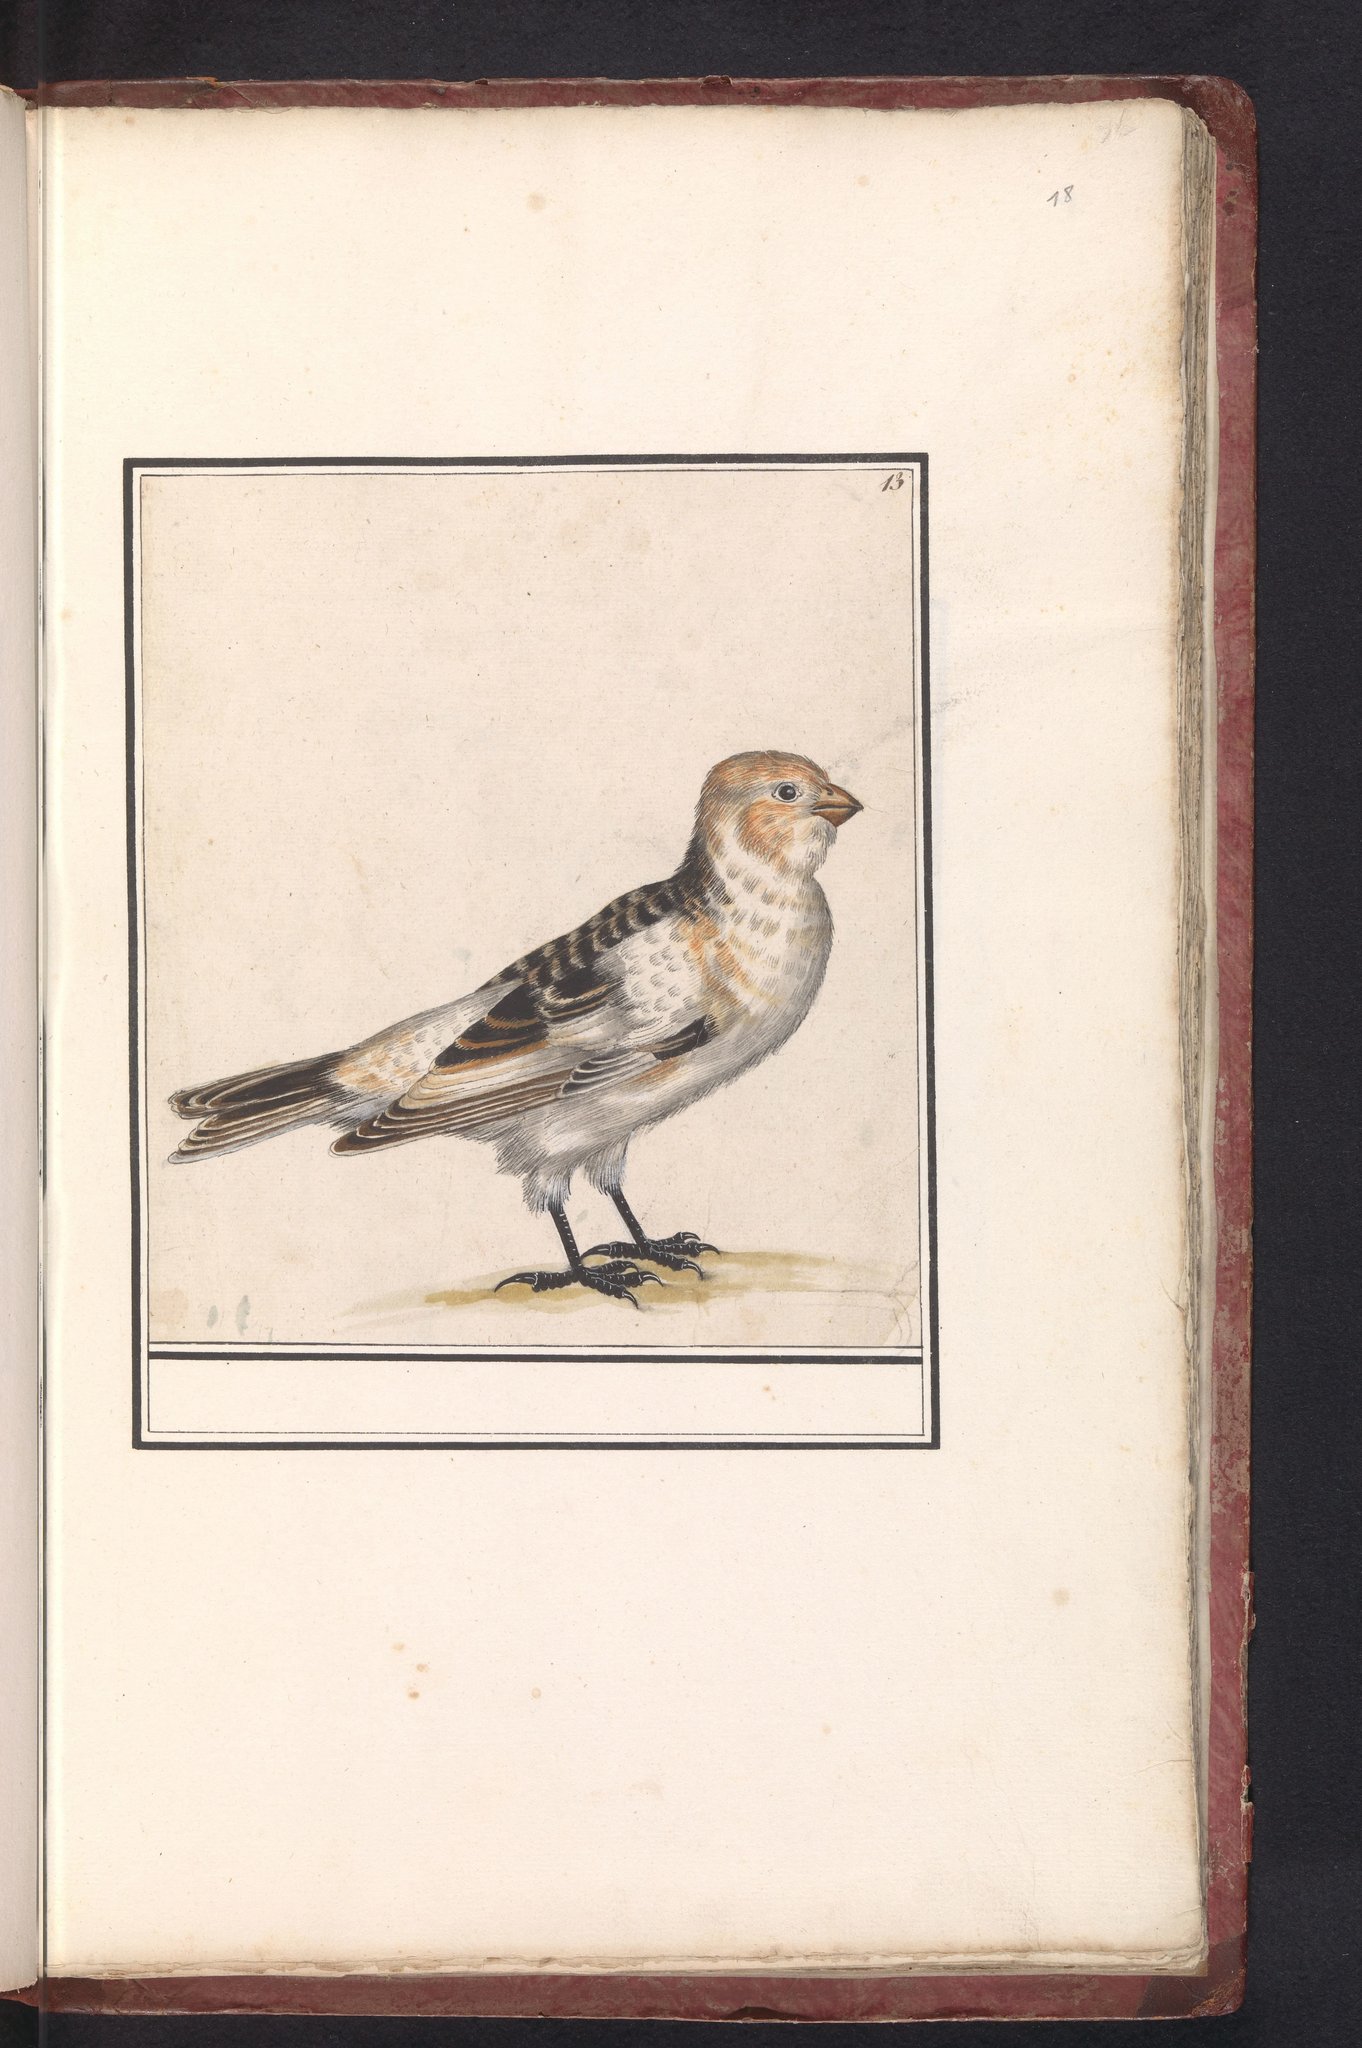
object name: drawing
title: Snow Bunting (Plectrophenax nivalis)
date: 1596-1610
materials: paint, paper, pencil, watercolor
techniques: brush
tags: song-birds: snow bunting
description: While in Prague, De Boodt could study living animals from distant lands in Rudolf II’s menagerie (zoo). He also had access to preserved specimens in the emperor’s Kunstkammer (Cabinet of Curiosities). Additionally, he relied on existing images to depict certain creatures. In the case of this snow bunting, De Boodt could simply observe it in the wild. Although the songbird breeds in the far northern regions of the world, it migrates south during the winter, including areas near Prague.